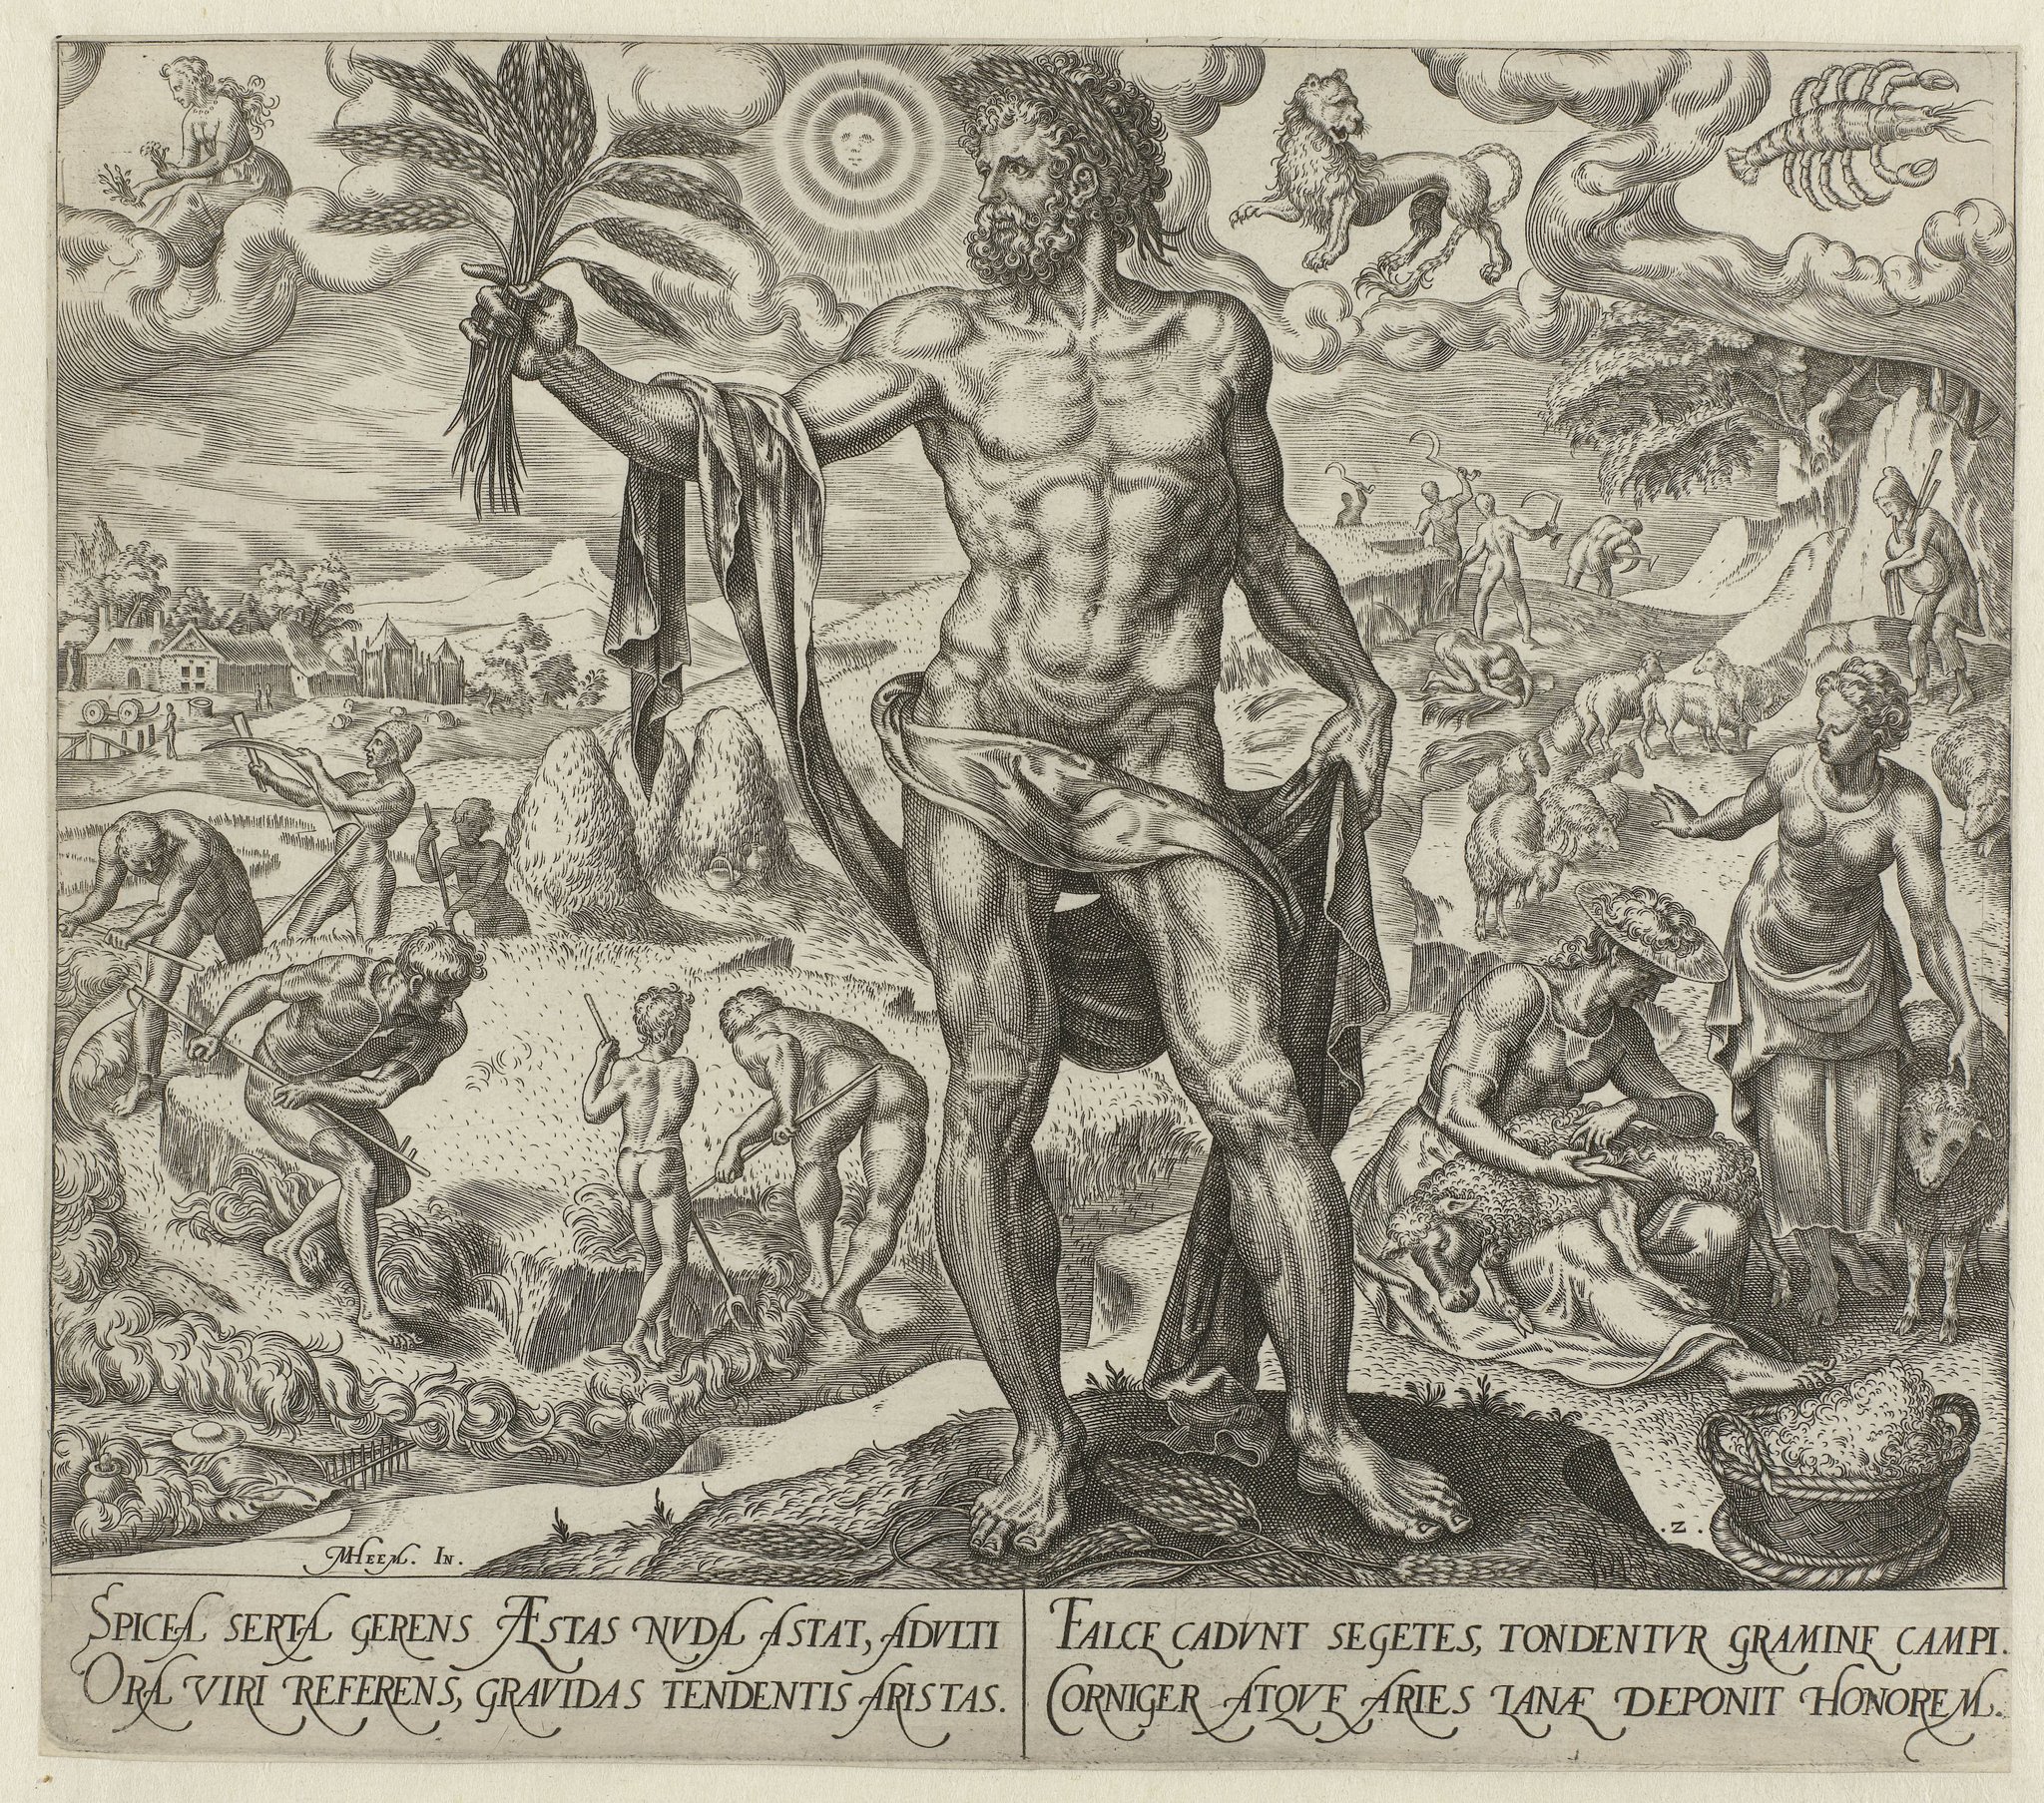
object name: print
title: Zomer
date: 1563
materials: paper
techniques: engraving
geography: haarlem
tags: summer, 'aestas'; 'estate' (ripa), summer landscape; landscape symbolizing summer (the four seasons of the year) (+ with scenes showing human occupations ~ seasons and months), summer landscape; landscape symbolizing summer (the four seasons of the year) (+ with zodiacal signs of the summer season)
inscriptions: collector's mark: Lugt 2228, collector's mark: Lugt 2760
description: In de voorgrond de personificatie van de Zomer: een volwassen man, gekroond met een korenkrans. In zijn handen enkele korenaren. Op de achtergrond zomertaferelen: hooiende en oogstende boeren. Schapen die worden gewassen en geschoren en een herder met zijn schapen. Boven in de lucht de drie astrologische tekens van de zomer: Kreeft, Leeuw en Maagd. De prent heeft een Latijns onderschrift en is deel van een vierdelige serie over de vier seizoenen.